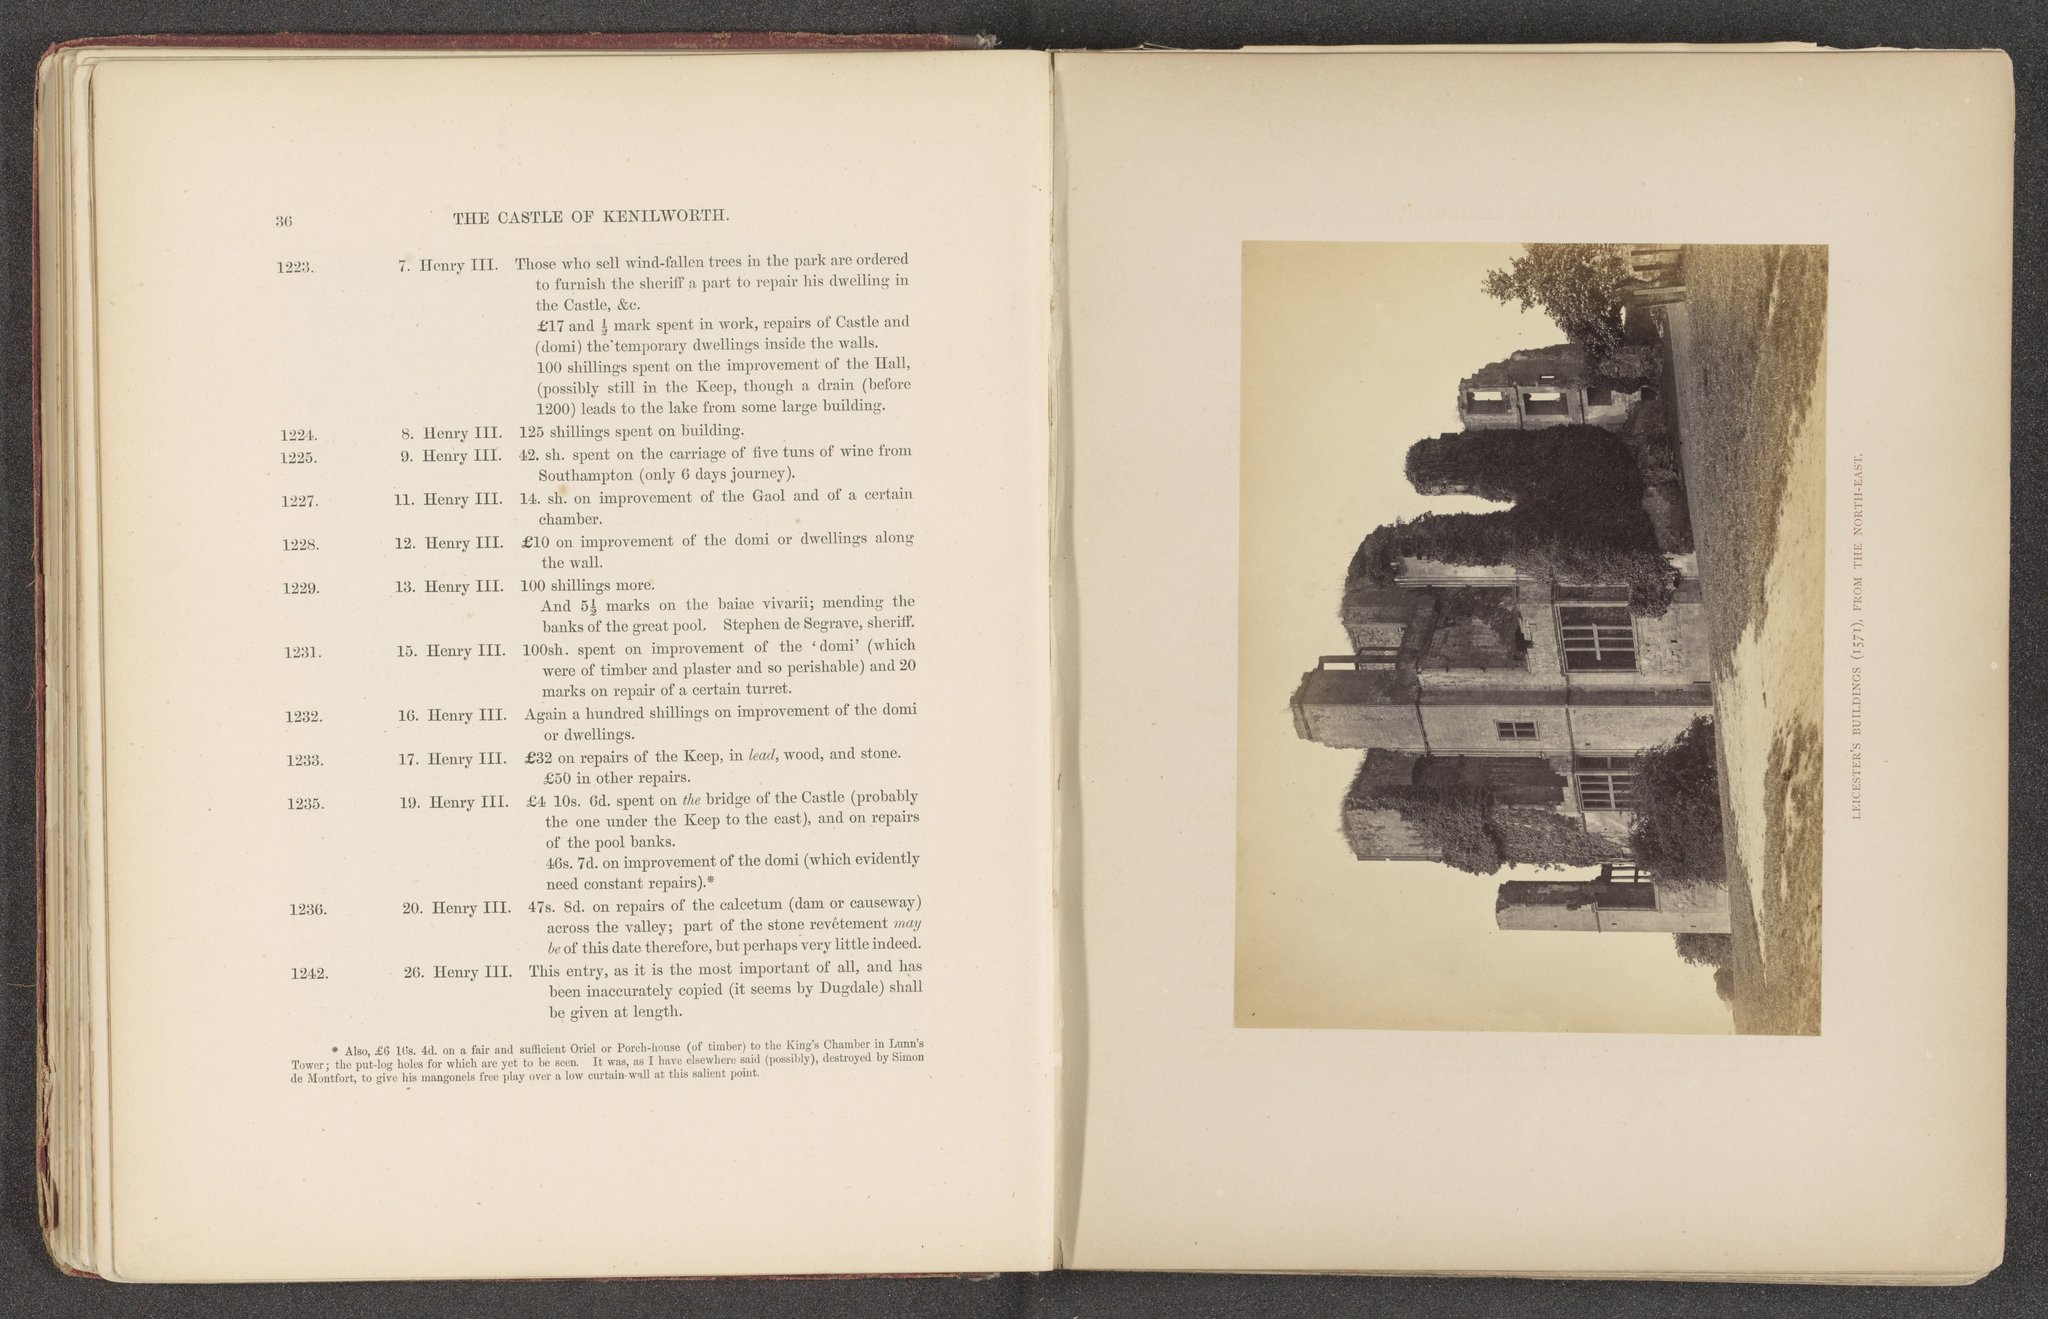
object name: page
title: Leicester's Buildings (1571), from the north-east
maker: Anonymous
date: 1862-1872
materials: photographic support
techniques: albumen print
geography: kenilworth castle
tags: tower, clock tower ~ monumental adornment, ruin of a dwelling, house, castle, etc.